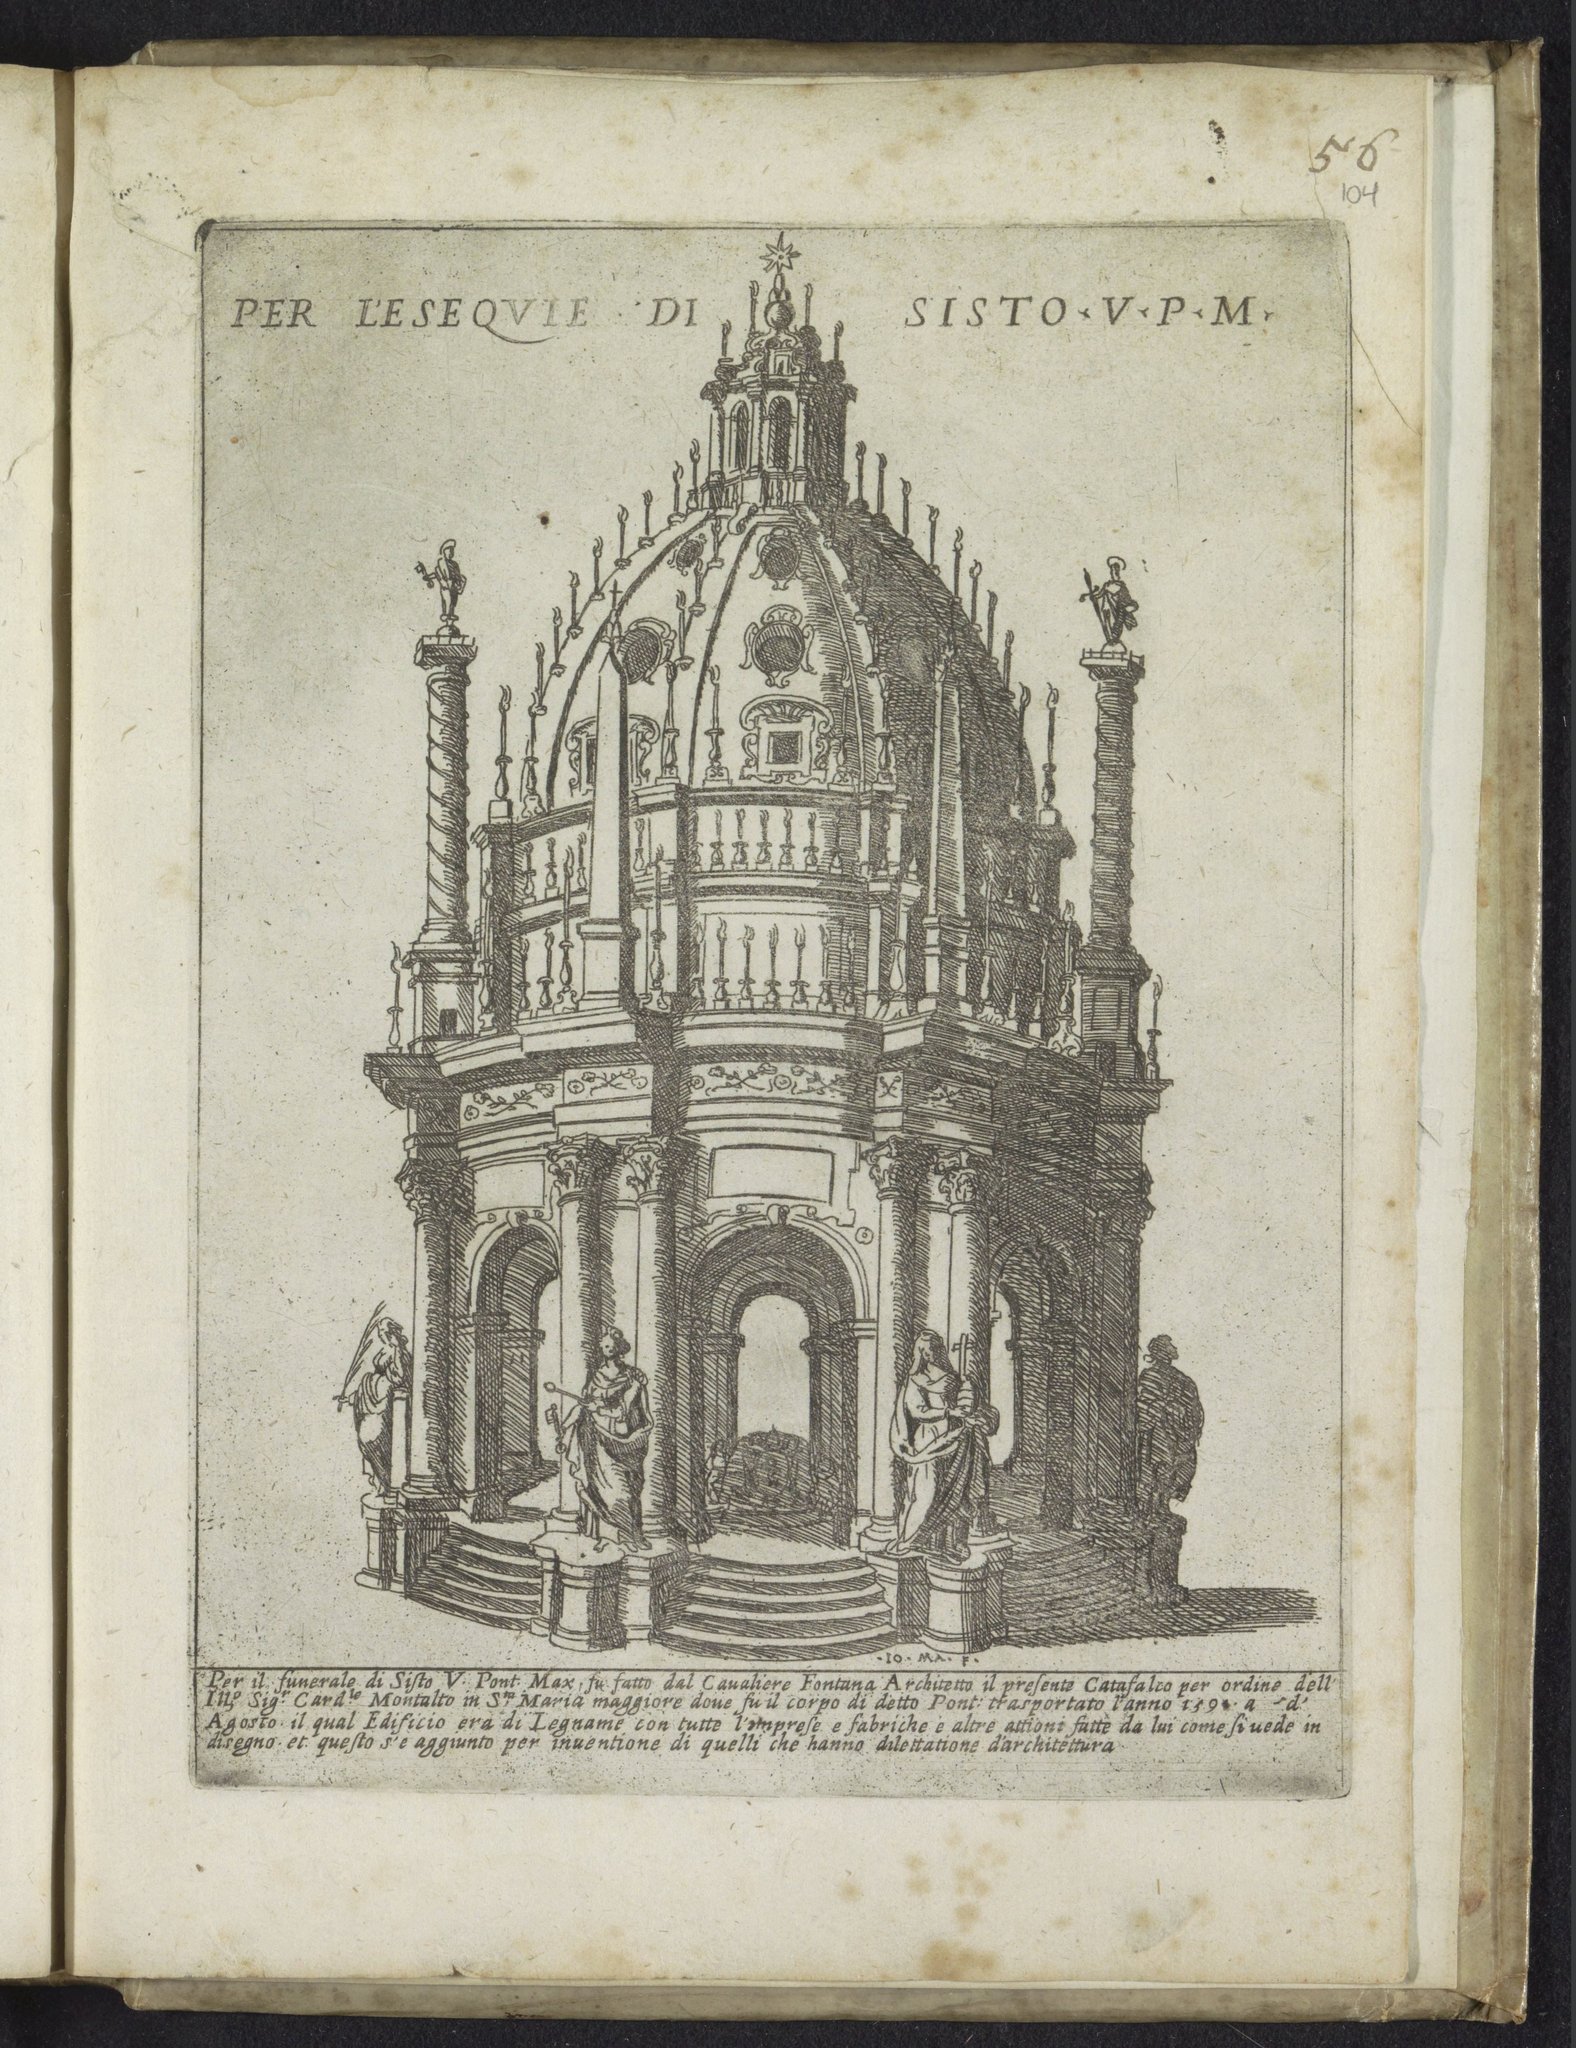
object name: print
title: Grafmonument voor paus Sixtus V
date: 1576-1618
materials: paper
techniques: etching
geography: rome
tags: sixtus v, grave, tomb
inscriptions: number: ‘56’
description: Tekst in het Italiaans onder de voorstelling. De prent maakt deel uit van een album.